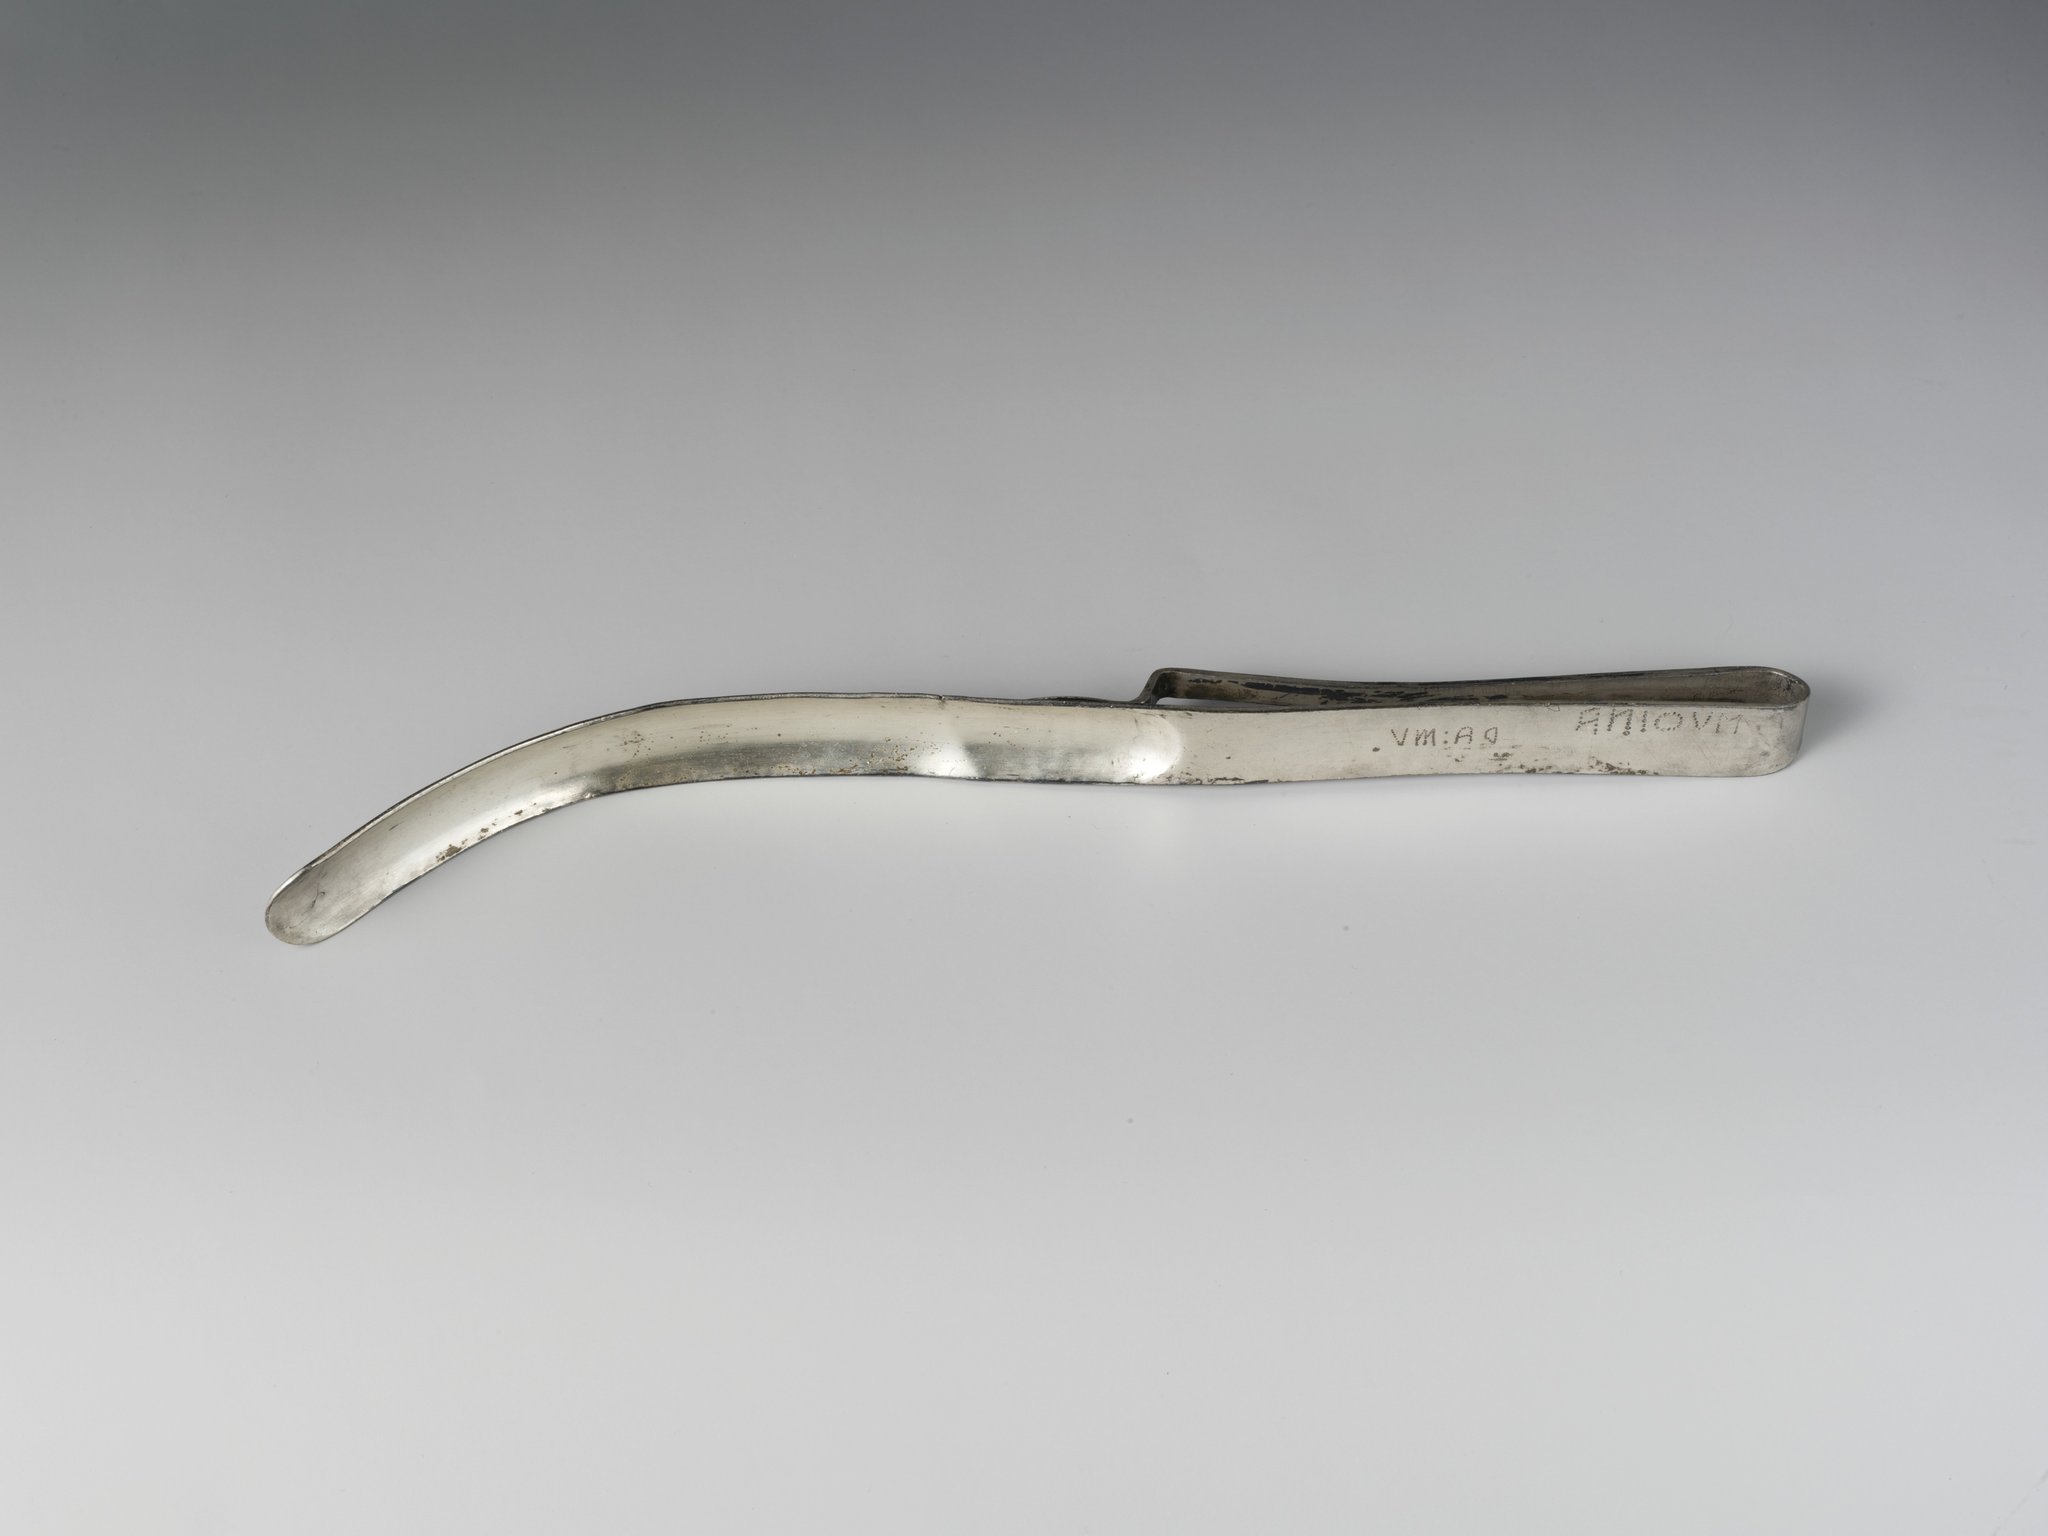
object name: strigil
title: Silver strigil (scraper)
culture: etruscan or italian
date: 300-268 BCE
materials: silver